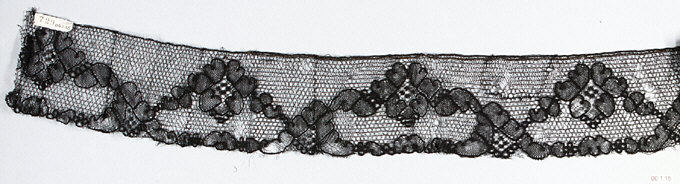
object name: fragment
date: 1801-1900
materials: silk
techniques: lace